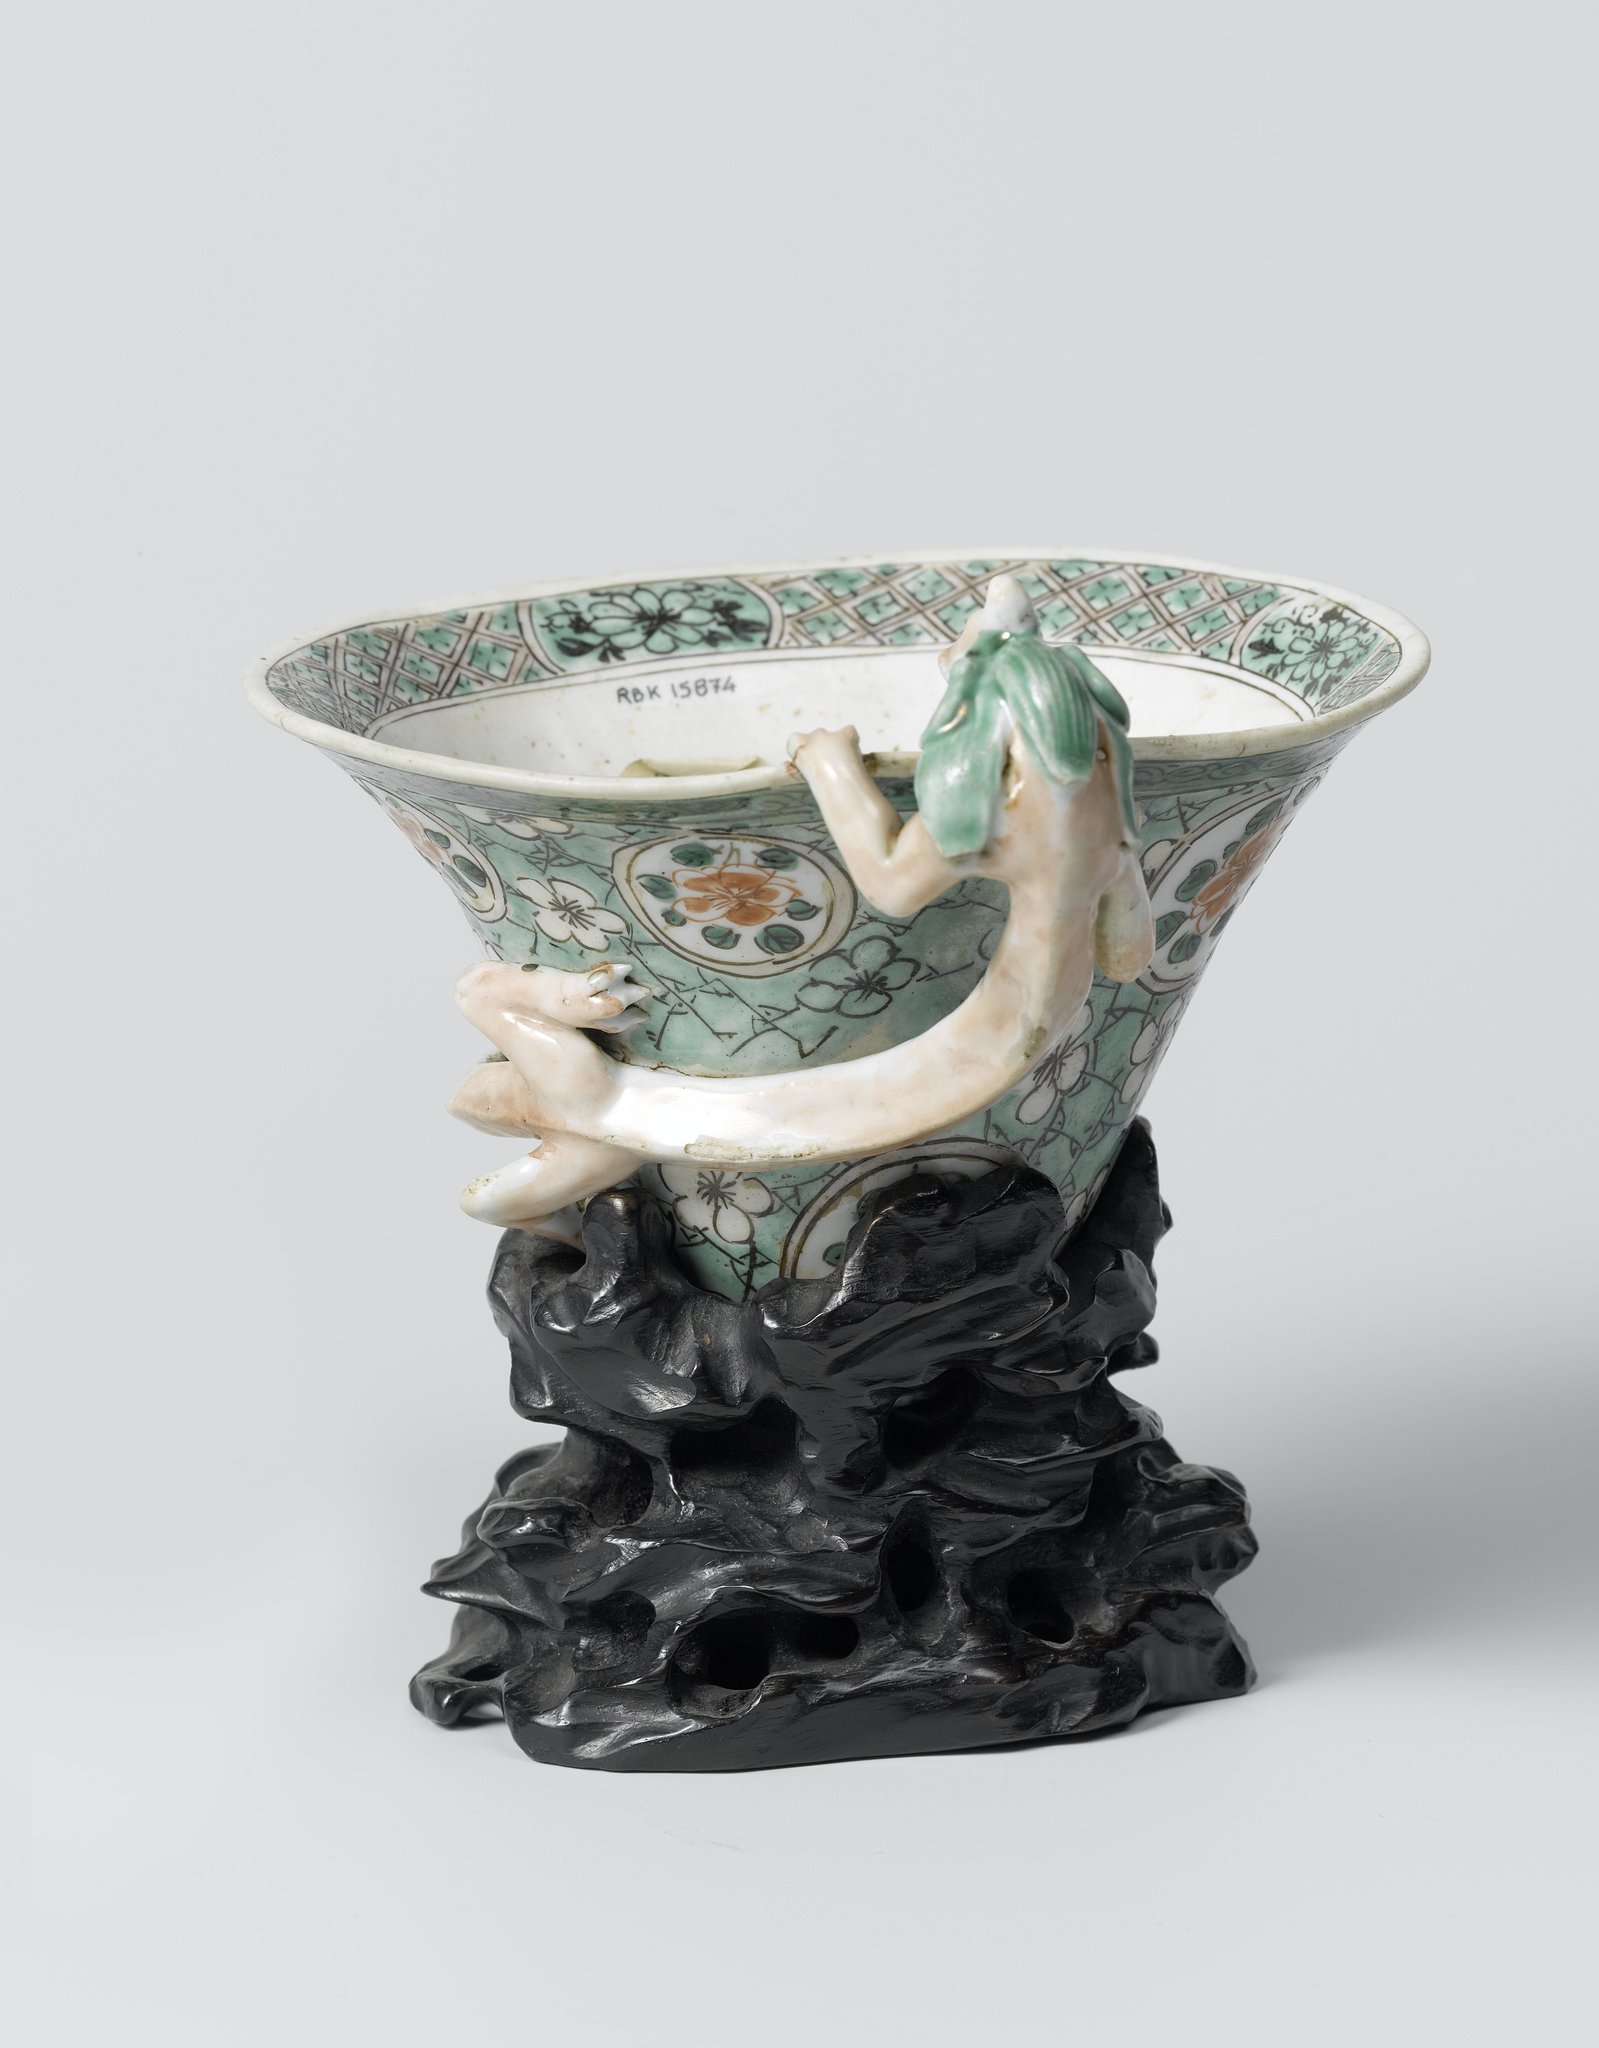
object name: cup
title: Libation cup with dragon-shaped handle and wooden stand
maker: Anonymous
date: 1700-1724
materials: paint, porcelain, wood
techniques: firing, turning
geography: china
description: Rituele kop van porselein met een spreidende wand en een houten, rotsvormige standaard, beschilderd op het biscuit in rood, groen en zwart. De buitenwand van de kop is bedekt met perzikbloesems (prunus) tegen een achtergrond van 'crackled ice'; hierin uitgespaard medaillons met een bloemtak. De buitenrand met een band met krulwerk. De binnenrand met een band servetwerk onderbroken door een cartouche met een bloem. Het oor is gemodelleerd in de vorm van een chilong (hoornloze draak). De houten standaard is van later datum. Email sur biscuit met famille verte kleuren.